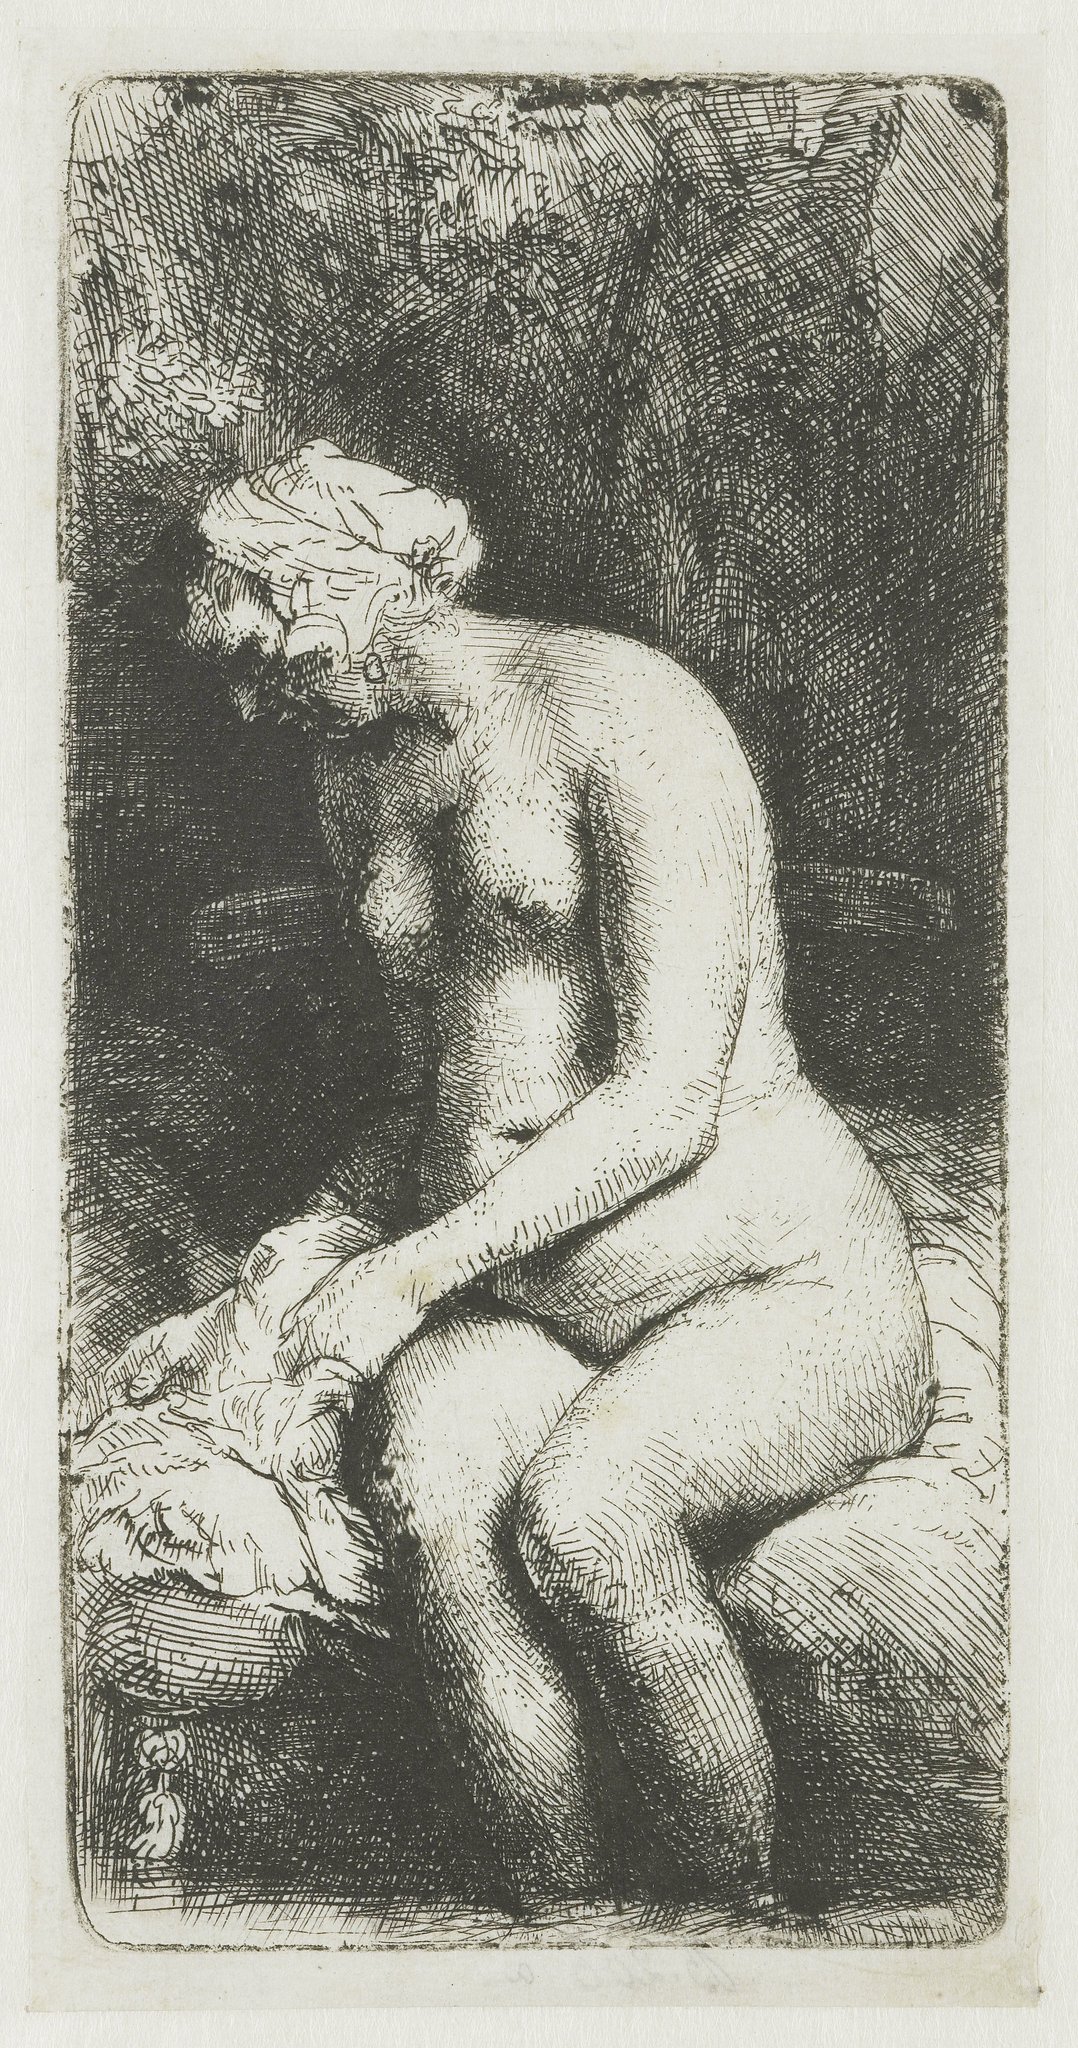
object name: print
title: Woman bathing her feet at a brook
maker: rembrandt van rijn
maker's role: draughtsman, painter, print maker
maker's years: 1606-1669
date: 1658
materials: paper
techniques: drypoint, etching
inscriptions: mark: Lugt 2228 a, signature and date: ‘Rembrandt f. 1658’